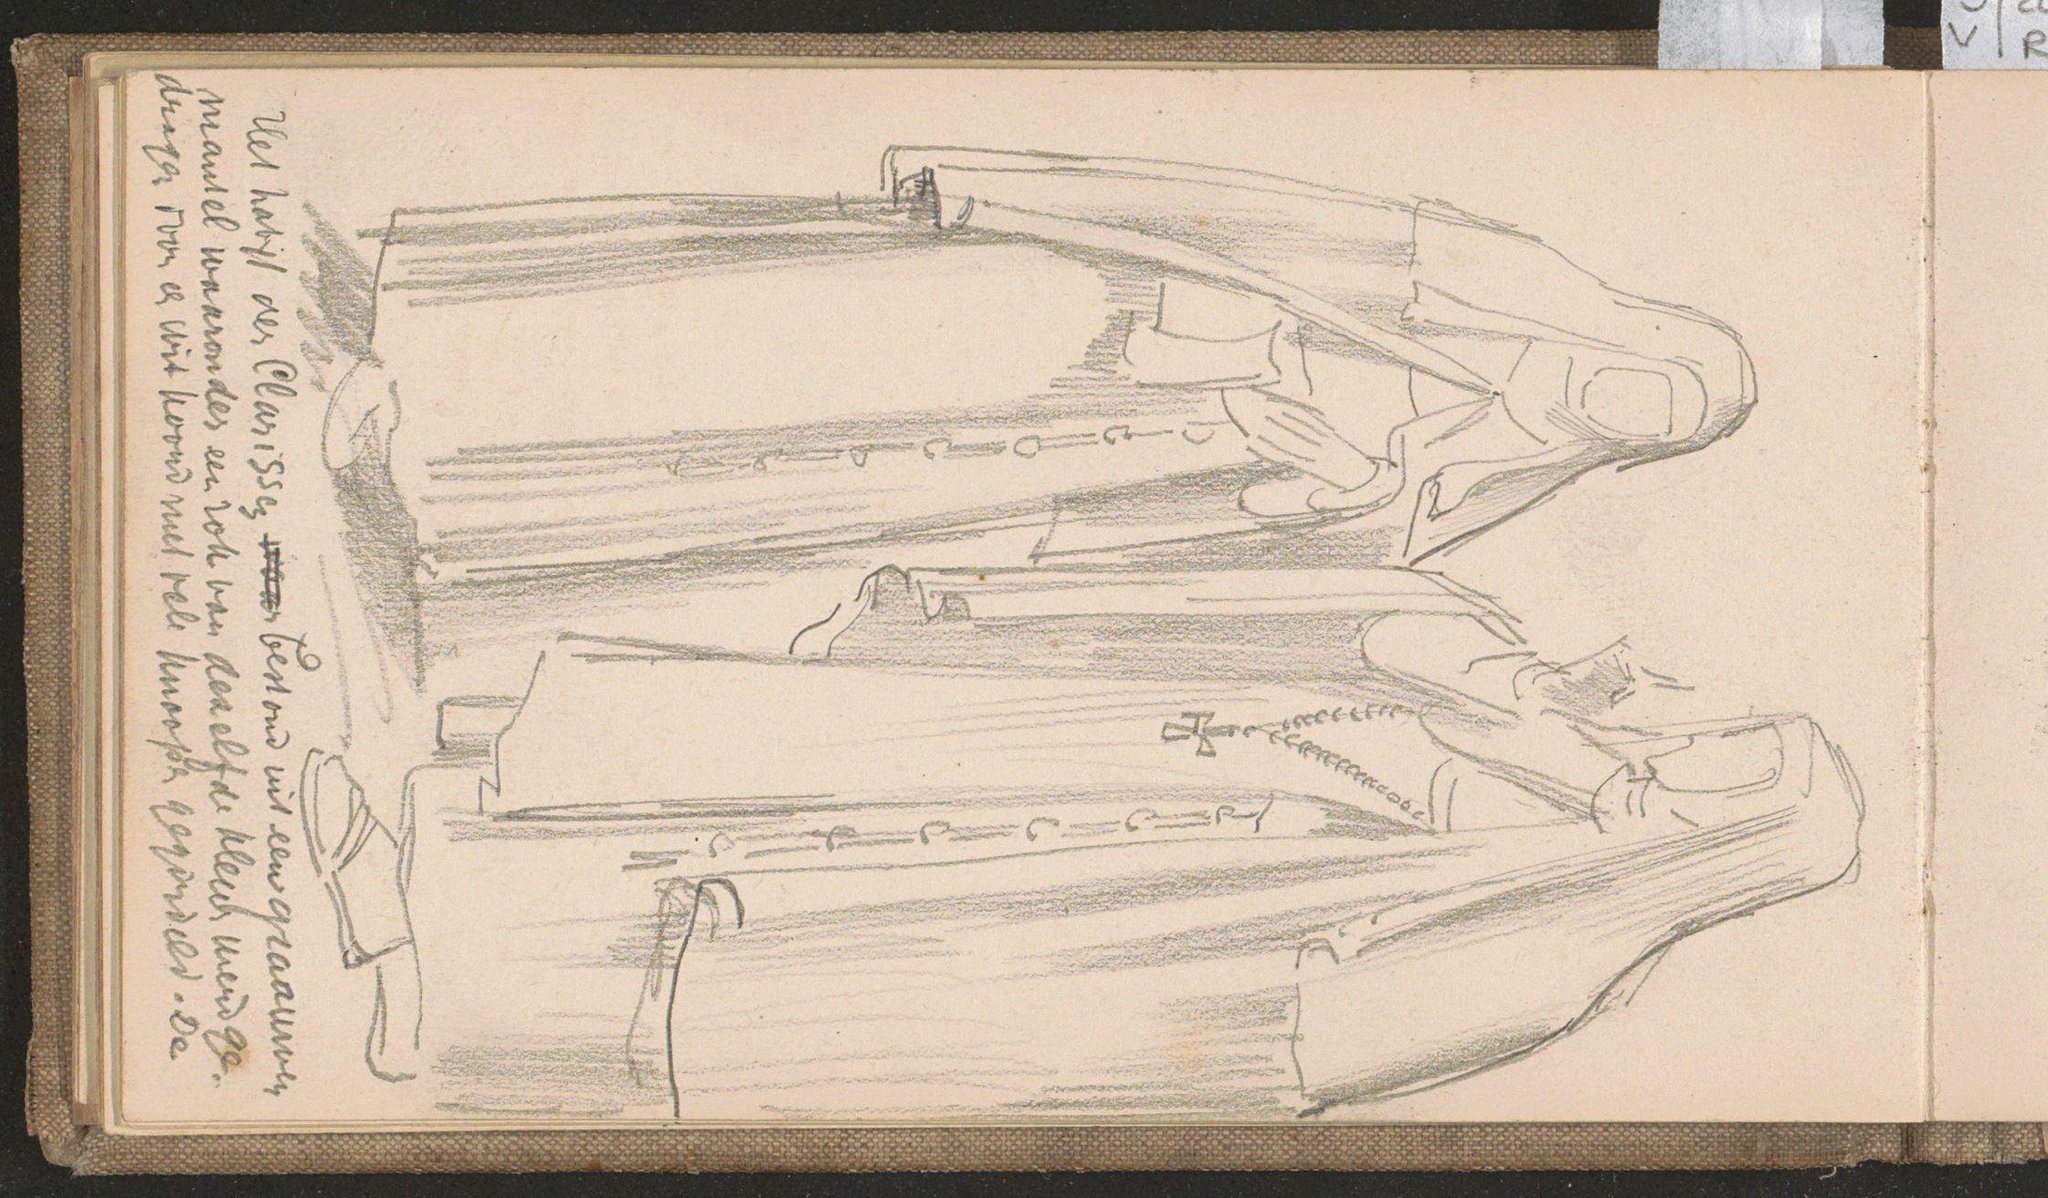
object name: sketchbook leaf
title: Twee nonnen van de orde van de Clarissen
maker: antoon derkinderen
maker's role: draughtsman, painter, print maker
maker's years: 1859-1925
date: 1892-1901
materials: paper, pencil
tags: nun(s)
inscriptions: annotation: ‘Het habijt der Clarissen bestond uit een graauwen/ mantel waaronder een rok van dezelfde kleur werd ge/ dragen voor & wit koord met vele knoopen gegordeld. De’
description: Blad 16 verso uit een schetsboek met 51 bladen.